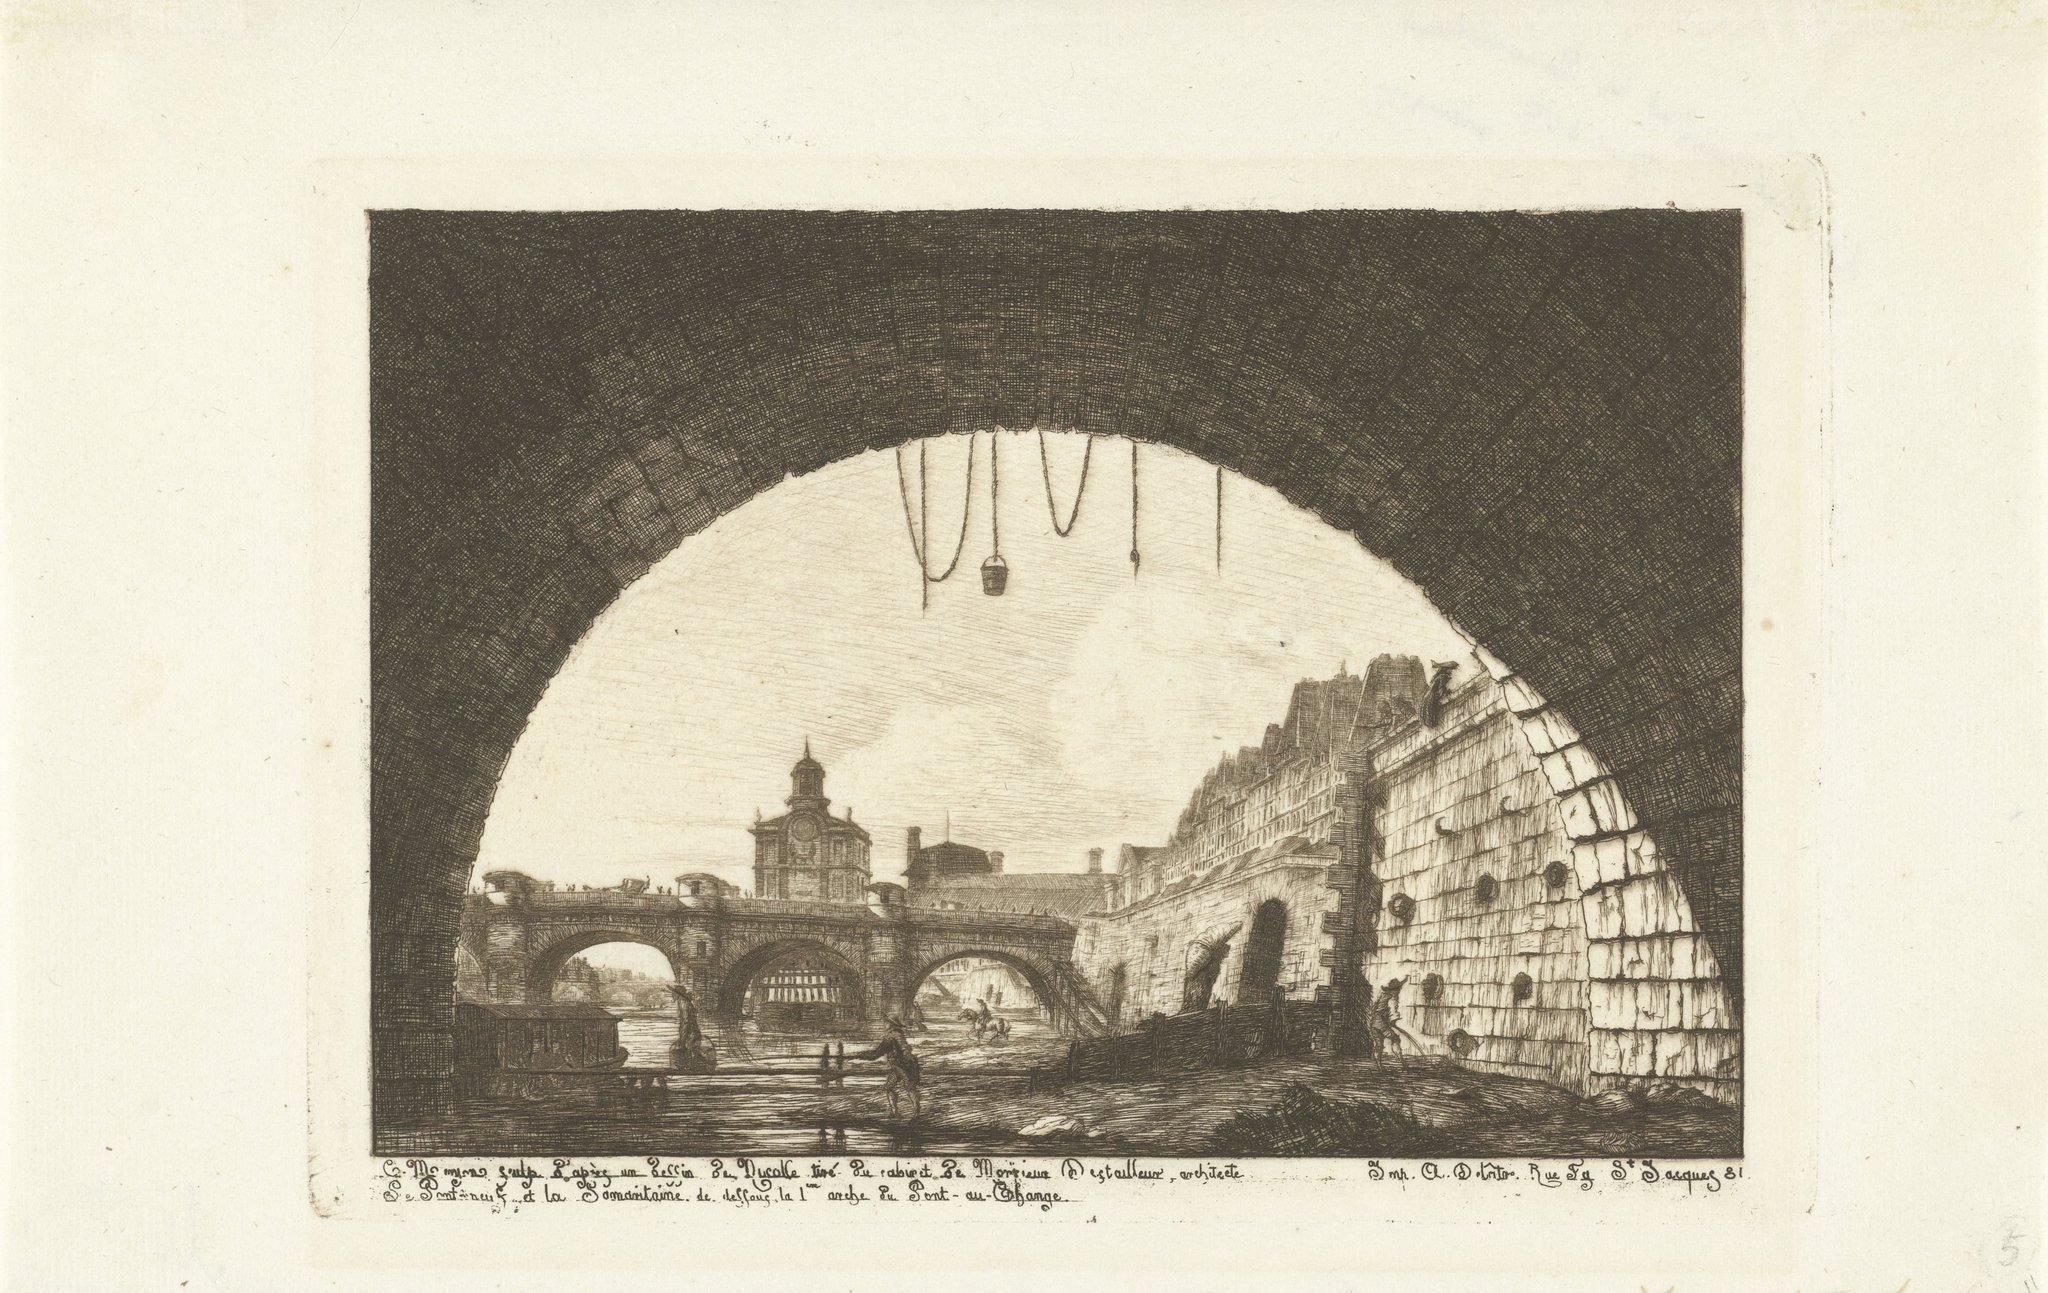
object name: print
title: Gezicht op Pont-Neuf van onder boog Pont-au-Change in Parijs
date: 1855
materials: paper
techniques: etching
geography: paris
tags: bridge in city across river, canal, etc.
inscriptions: collector's mark: Lugt 690, collector's mark:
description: Gezicht op de Pont-Neuf en het pompgebouw La Samaritaine van onder de eerste boog van de Pont-au-Change in Parijs.